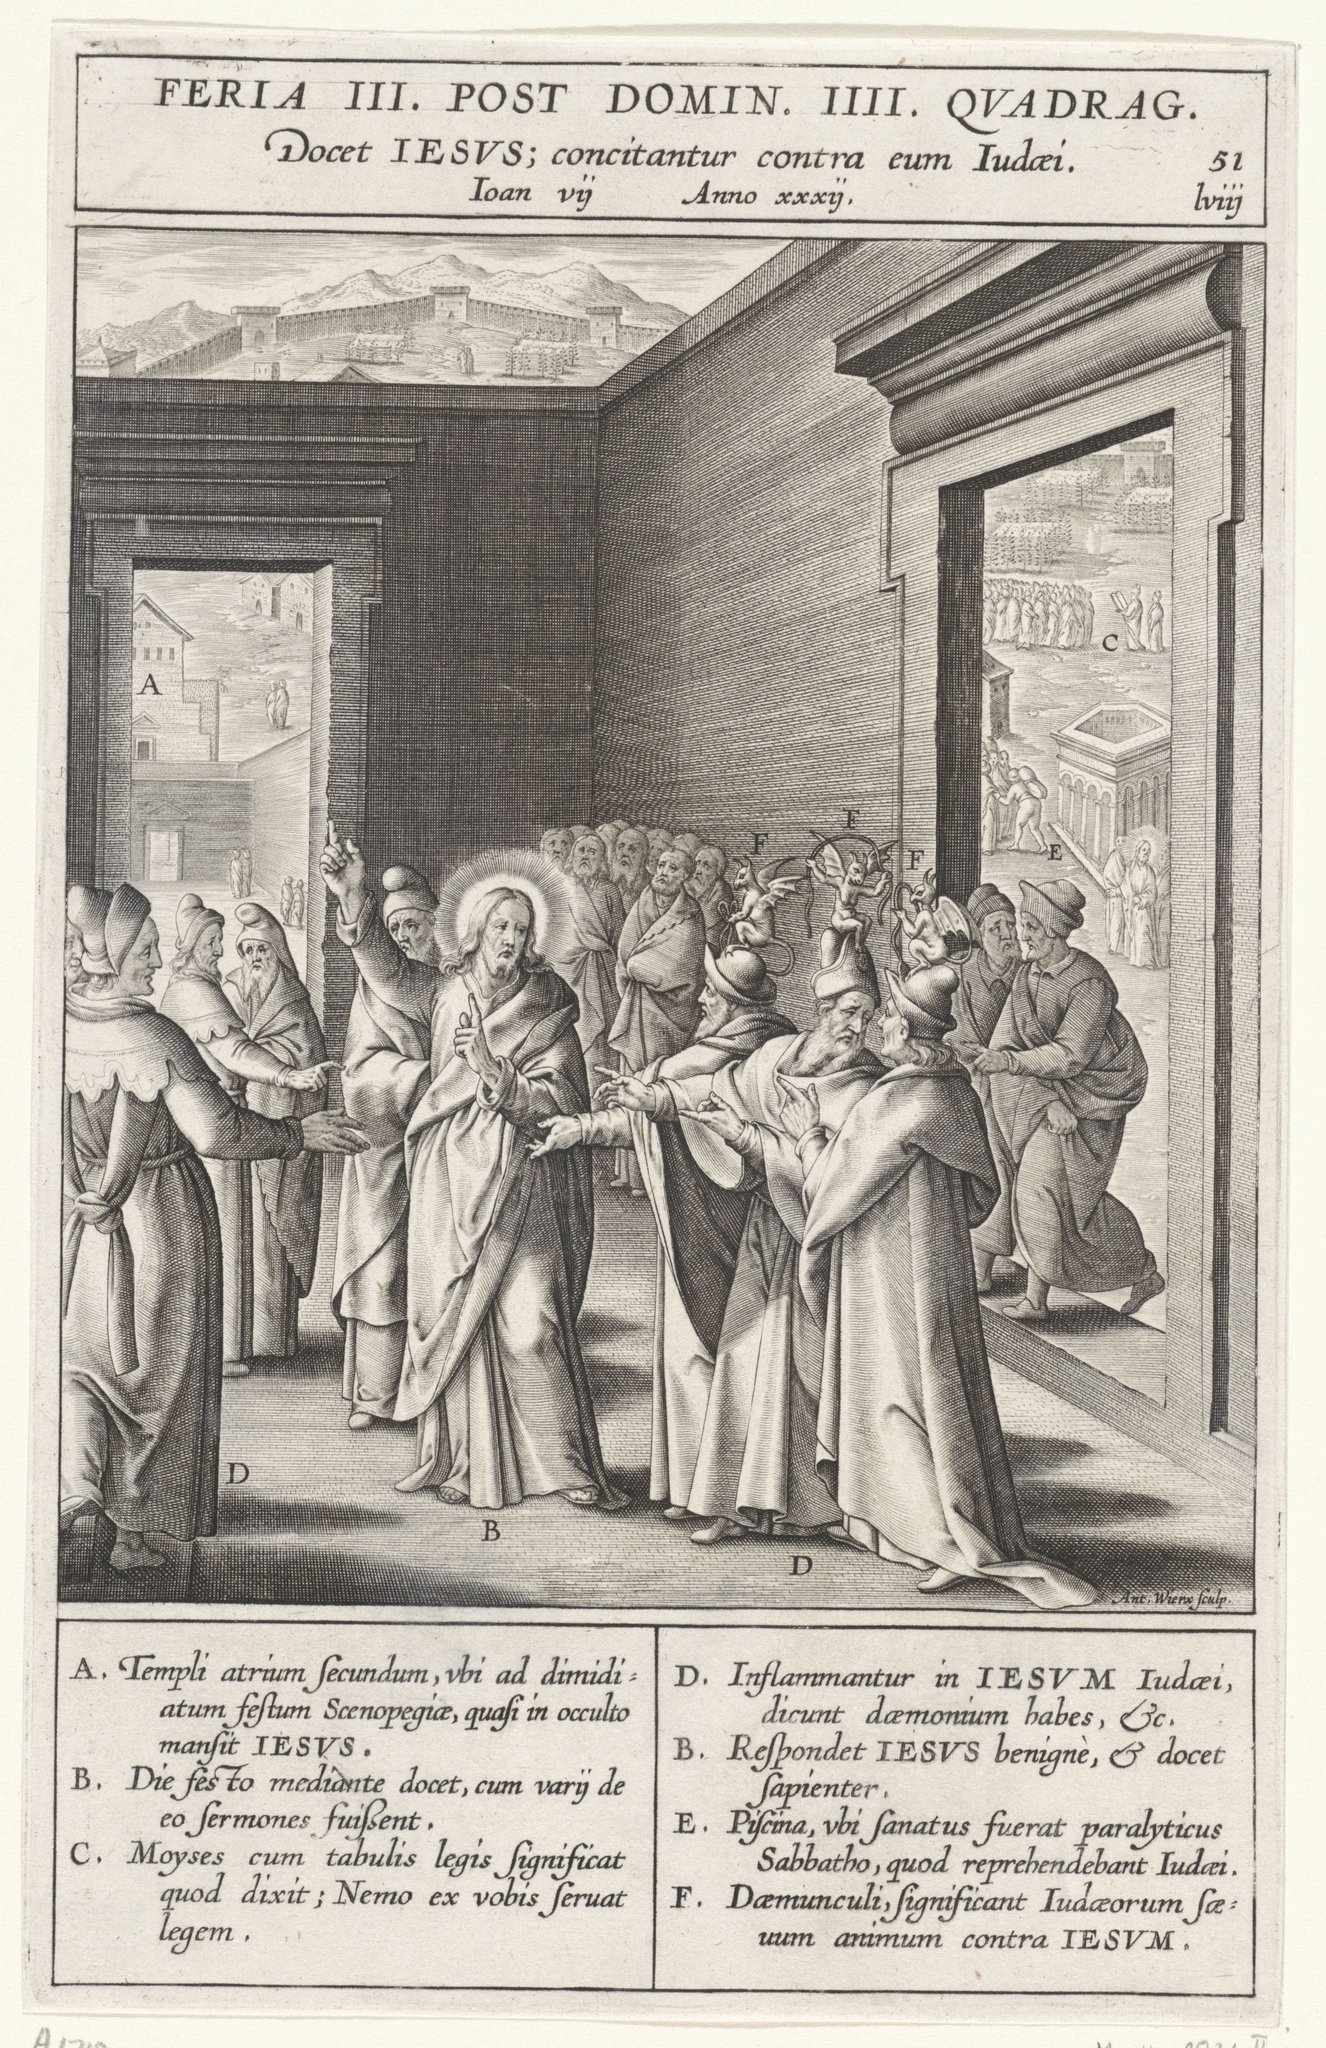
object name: print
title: Preek van Christus in de tempel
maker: antonie wierix (ii)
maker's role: draughtsman, print maker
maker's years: 1555-1604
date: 1593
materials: paper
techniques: engraving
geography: antwerp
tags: christ is teaching in the temple in the middle of the feast of tabernacles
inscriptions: collector's mark: Lugt 2165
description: Halverwege het Loofhuttenfeest gaat Christus naar de tempel om zijn leer te onderrichten. Bij verschillende elementen uit de voorstelling staan letters die corresponderen met de legenda in de marge.